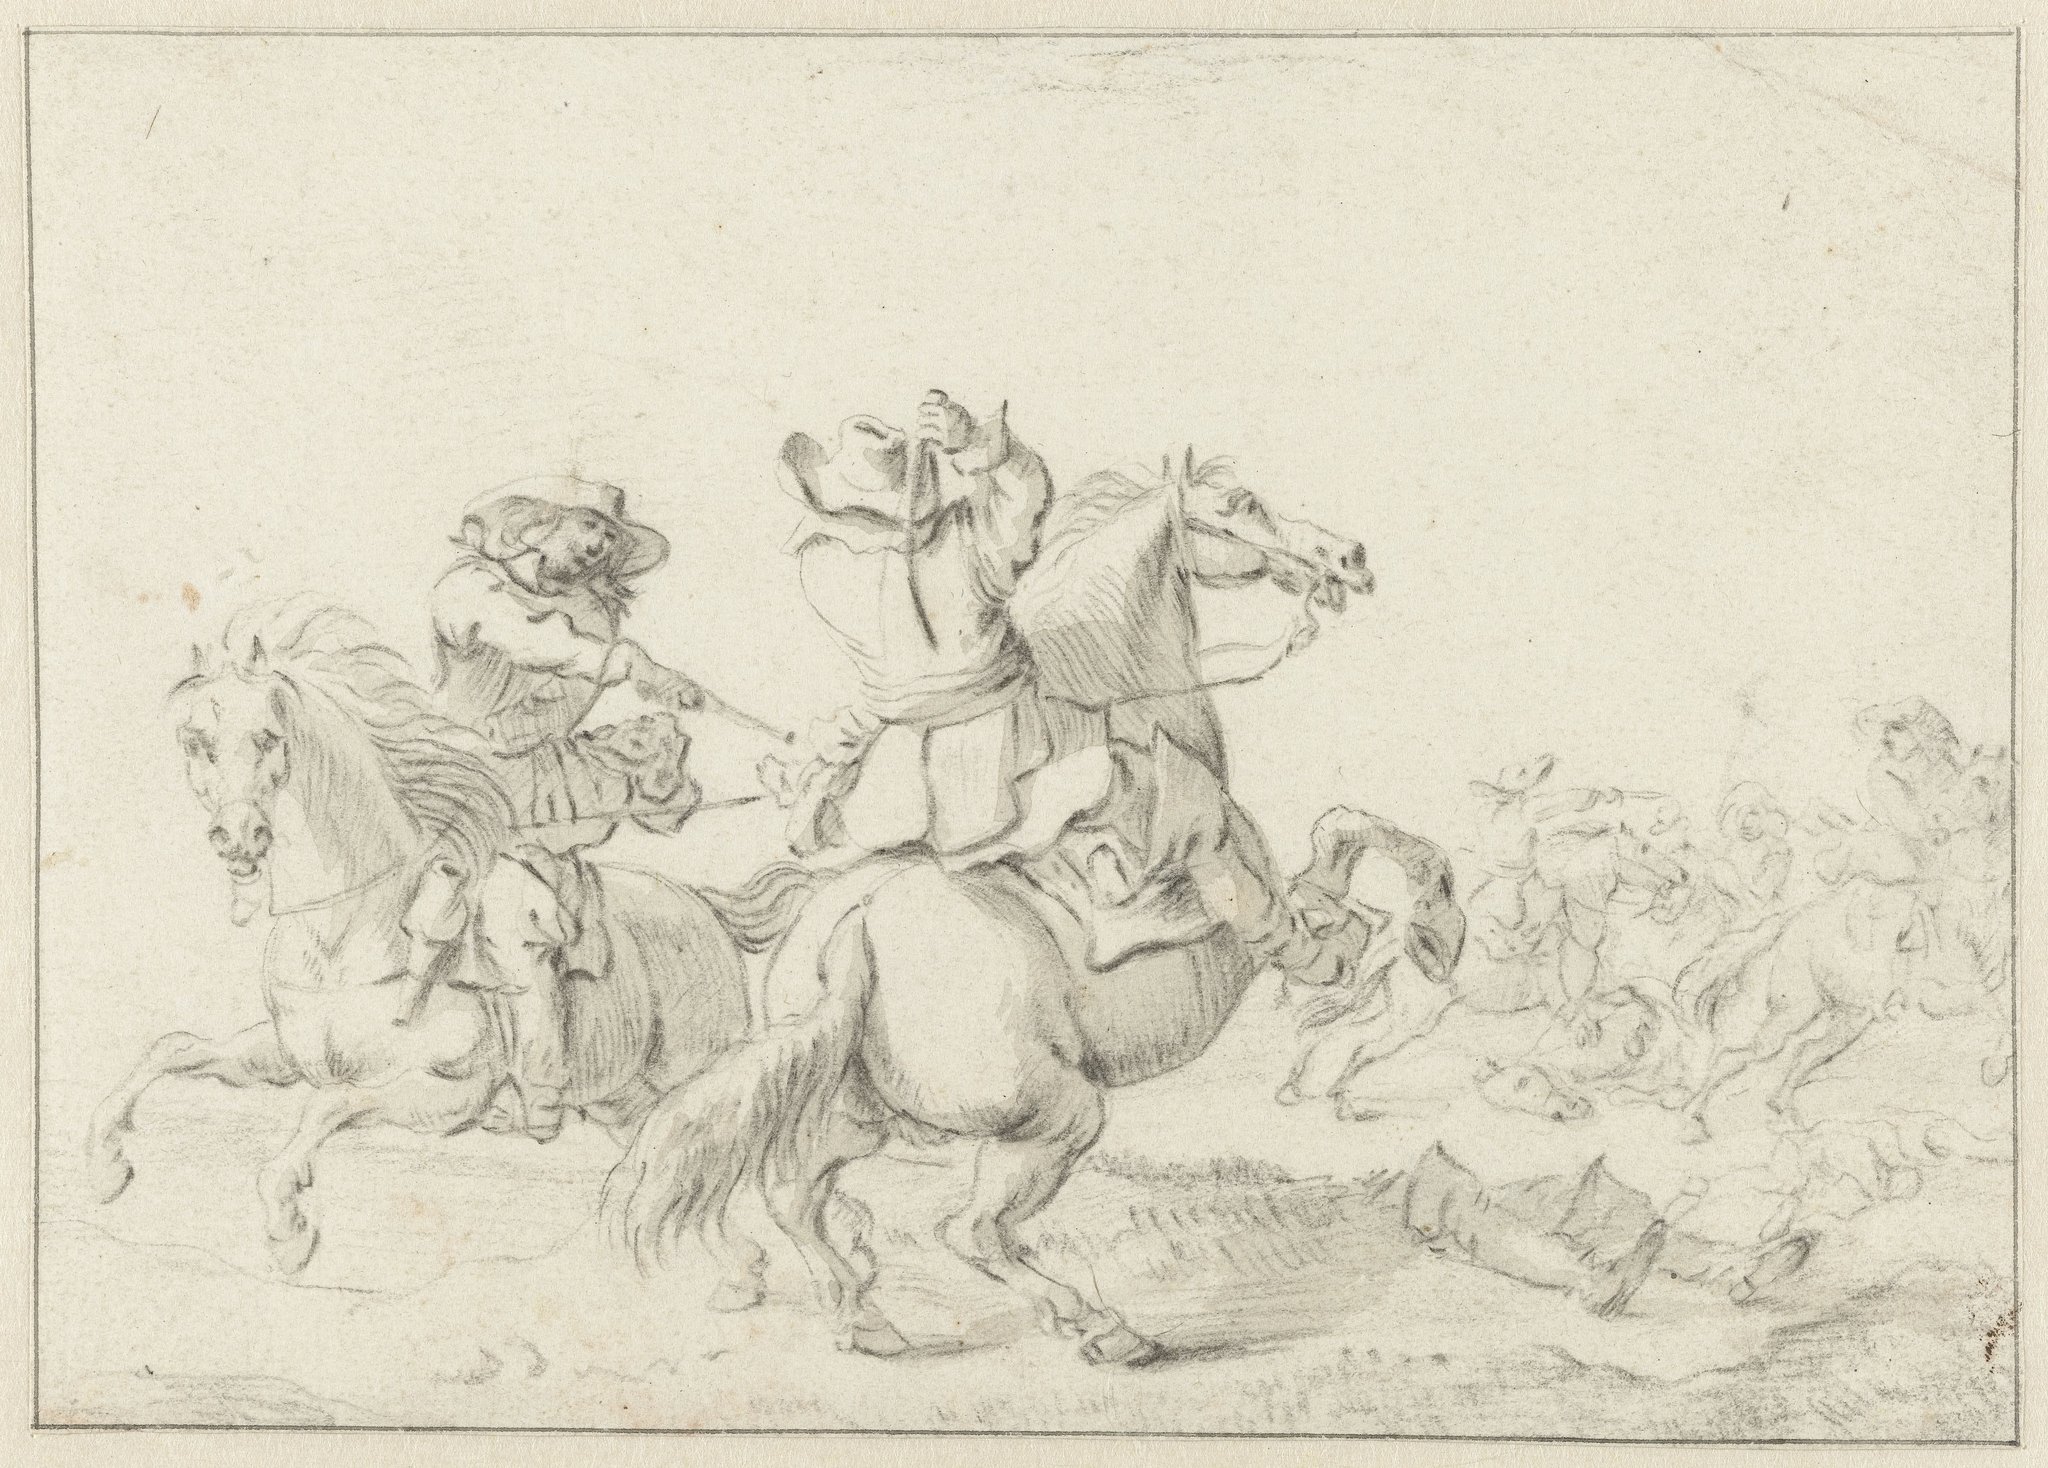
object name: drawing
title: Schermutseling tussen ruiters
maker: jan martszen de jonge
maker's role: draughtsman, painter, print maker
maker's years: 1609-1647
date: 1600-1650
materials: chalk, paper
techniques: brush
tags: battle (+ cavalry, horsemen)